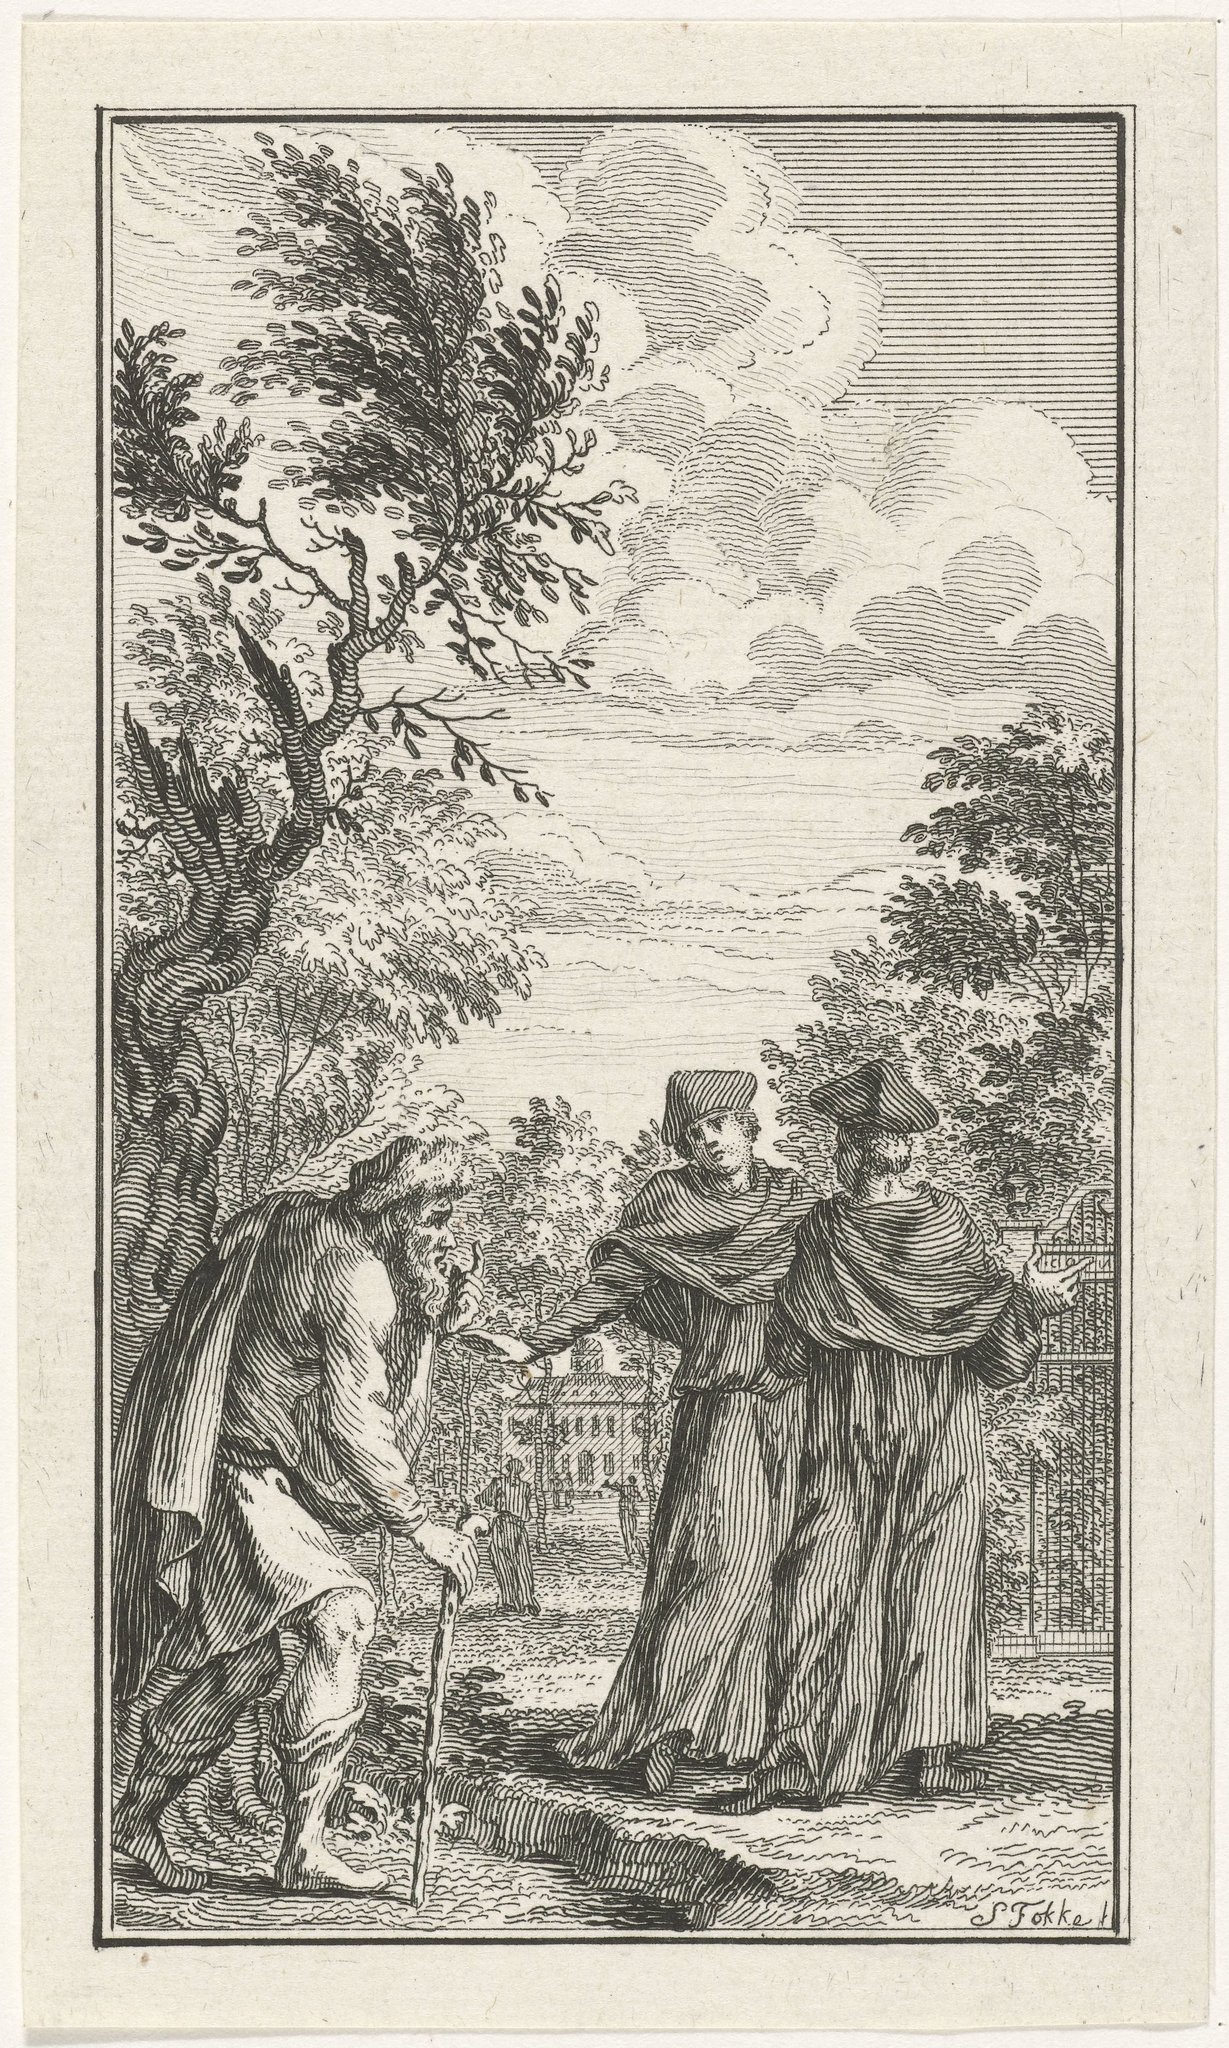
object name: print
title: Oude man spreekt twee geestelijken aan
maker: simon fokke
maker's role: draughtsman, print maker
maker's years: 1712-1784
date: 1722-1784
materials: paper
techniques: etching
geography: amsterdam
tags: old man, postures and gestures of the index finger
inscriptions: collector's mark: Lugt 240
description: Een oude bebaarde man met wandelstok wenkt met zijn vinger twee geestelijken. De linker geestelijke haalt met licht geheven armen zijn schouders naar de oude man op.